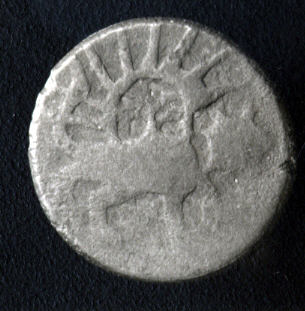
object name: coin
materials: copper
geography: iran